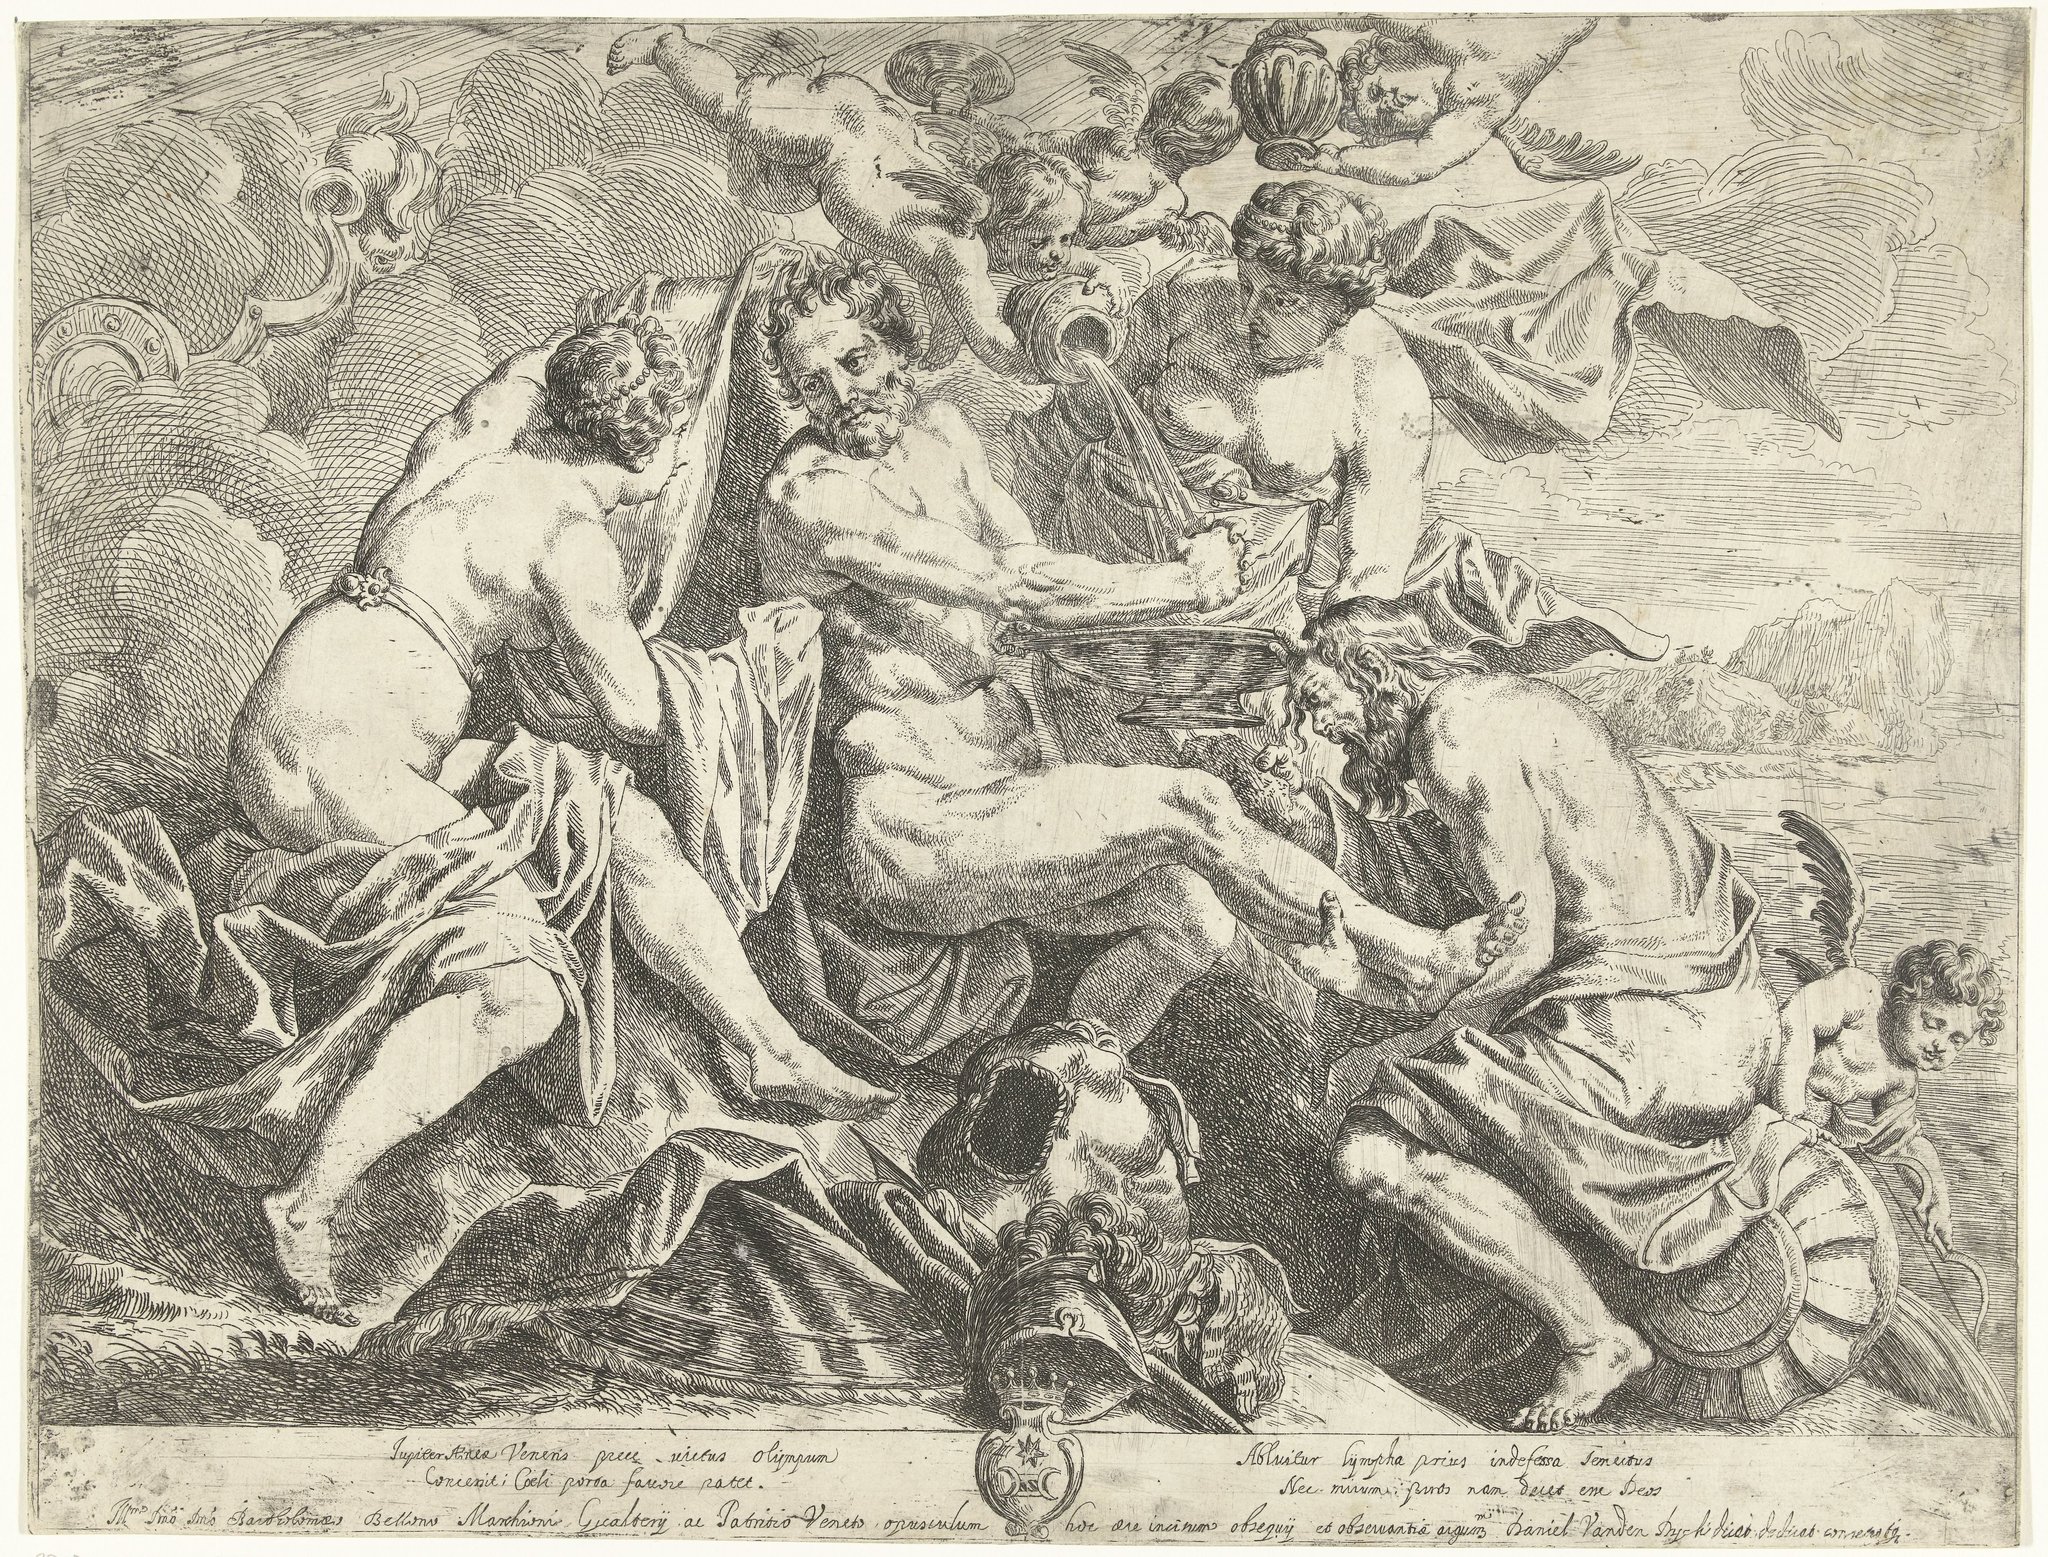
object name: print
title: De deïficatie van Aeneas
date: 1635-1670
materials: paper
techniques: etching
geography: italy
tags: the river-god numicus washes away aeneas' mortal parts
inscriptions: collector's mark: Lugt 2228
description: Een riviergod wast alle sterfelijke overblijfselen van Aeneas lichaam, vlak voor zijn deïficatie. Twee waternimfen helpen hem. Een putto brengt het water. Op de grond ligt Aeneas wapenrusting. Onder de voorstelling een Latijns vers en een opdracht.